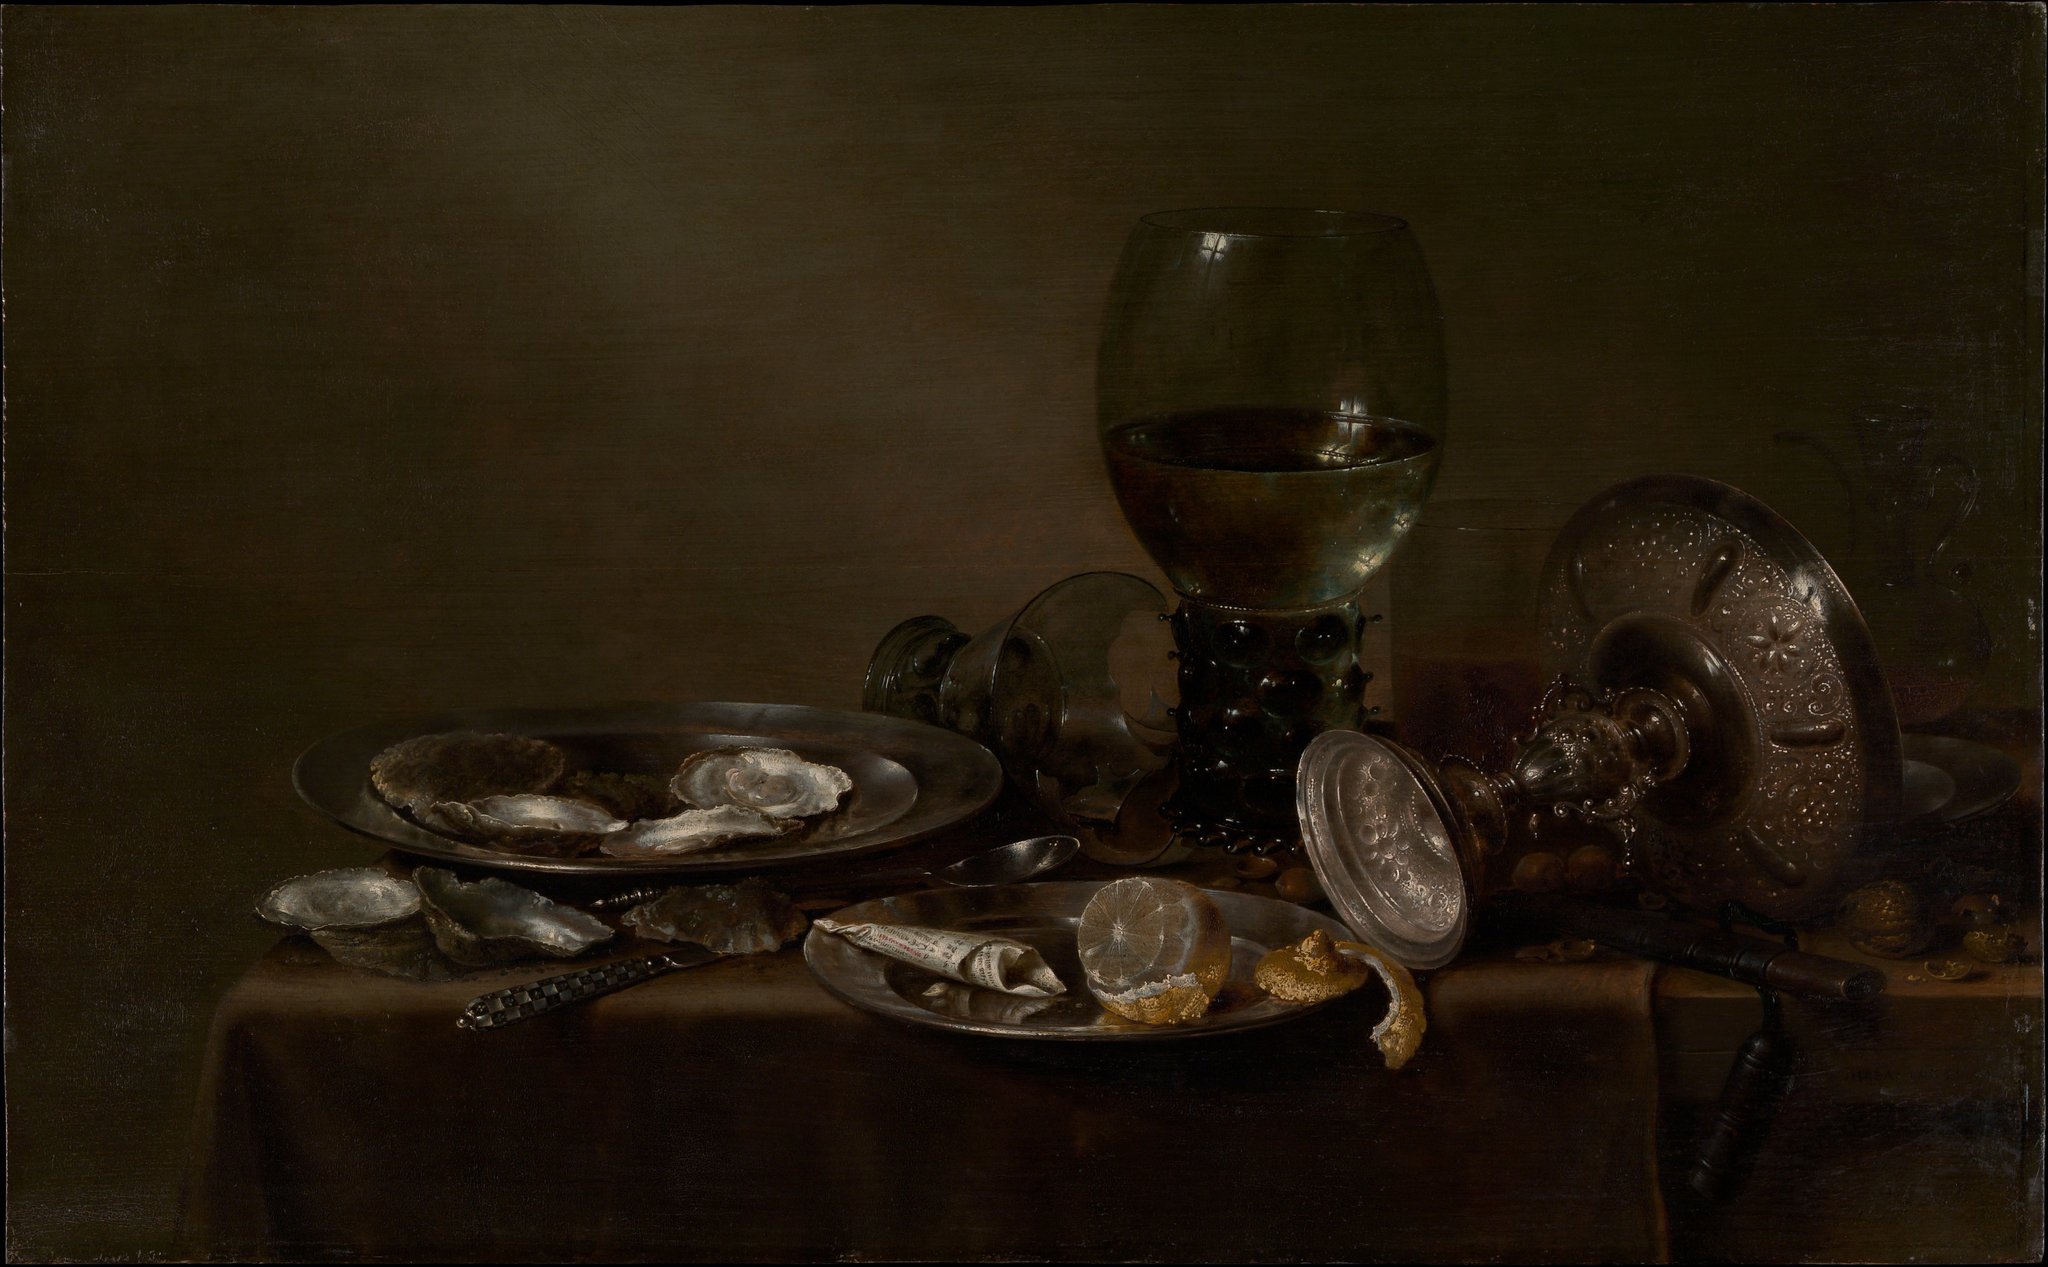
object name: painting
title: Still Life with Oysters, a Silver Tazza, and Glassware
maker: willem claesz heda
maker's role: artist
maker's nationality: dutch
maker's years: 1594-1680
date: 1635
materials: oil, wood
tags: lemons,still life,drinking glasses,oysters